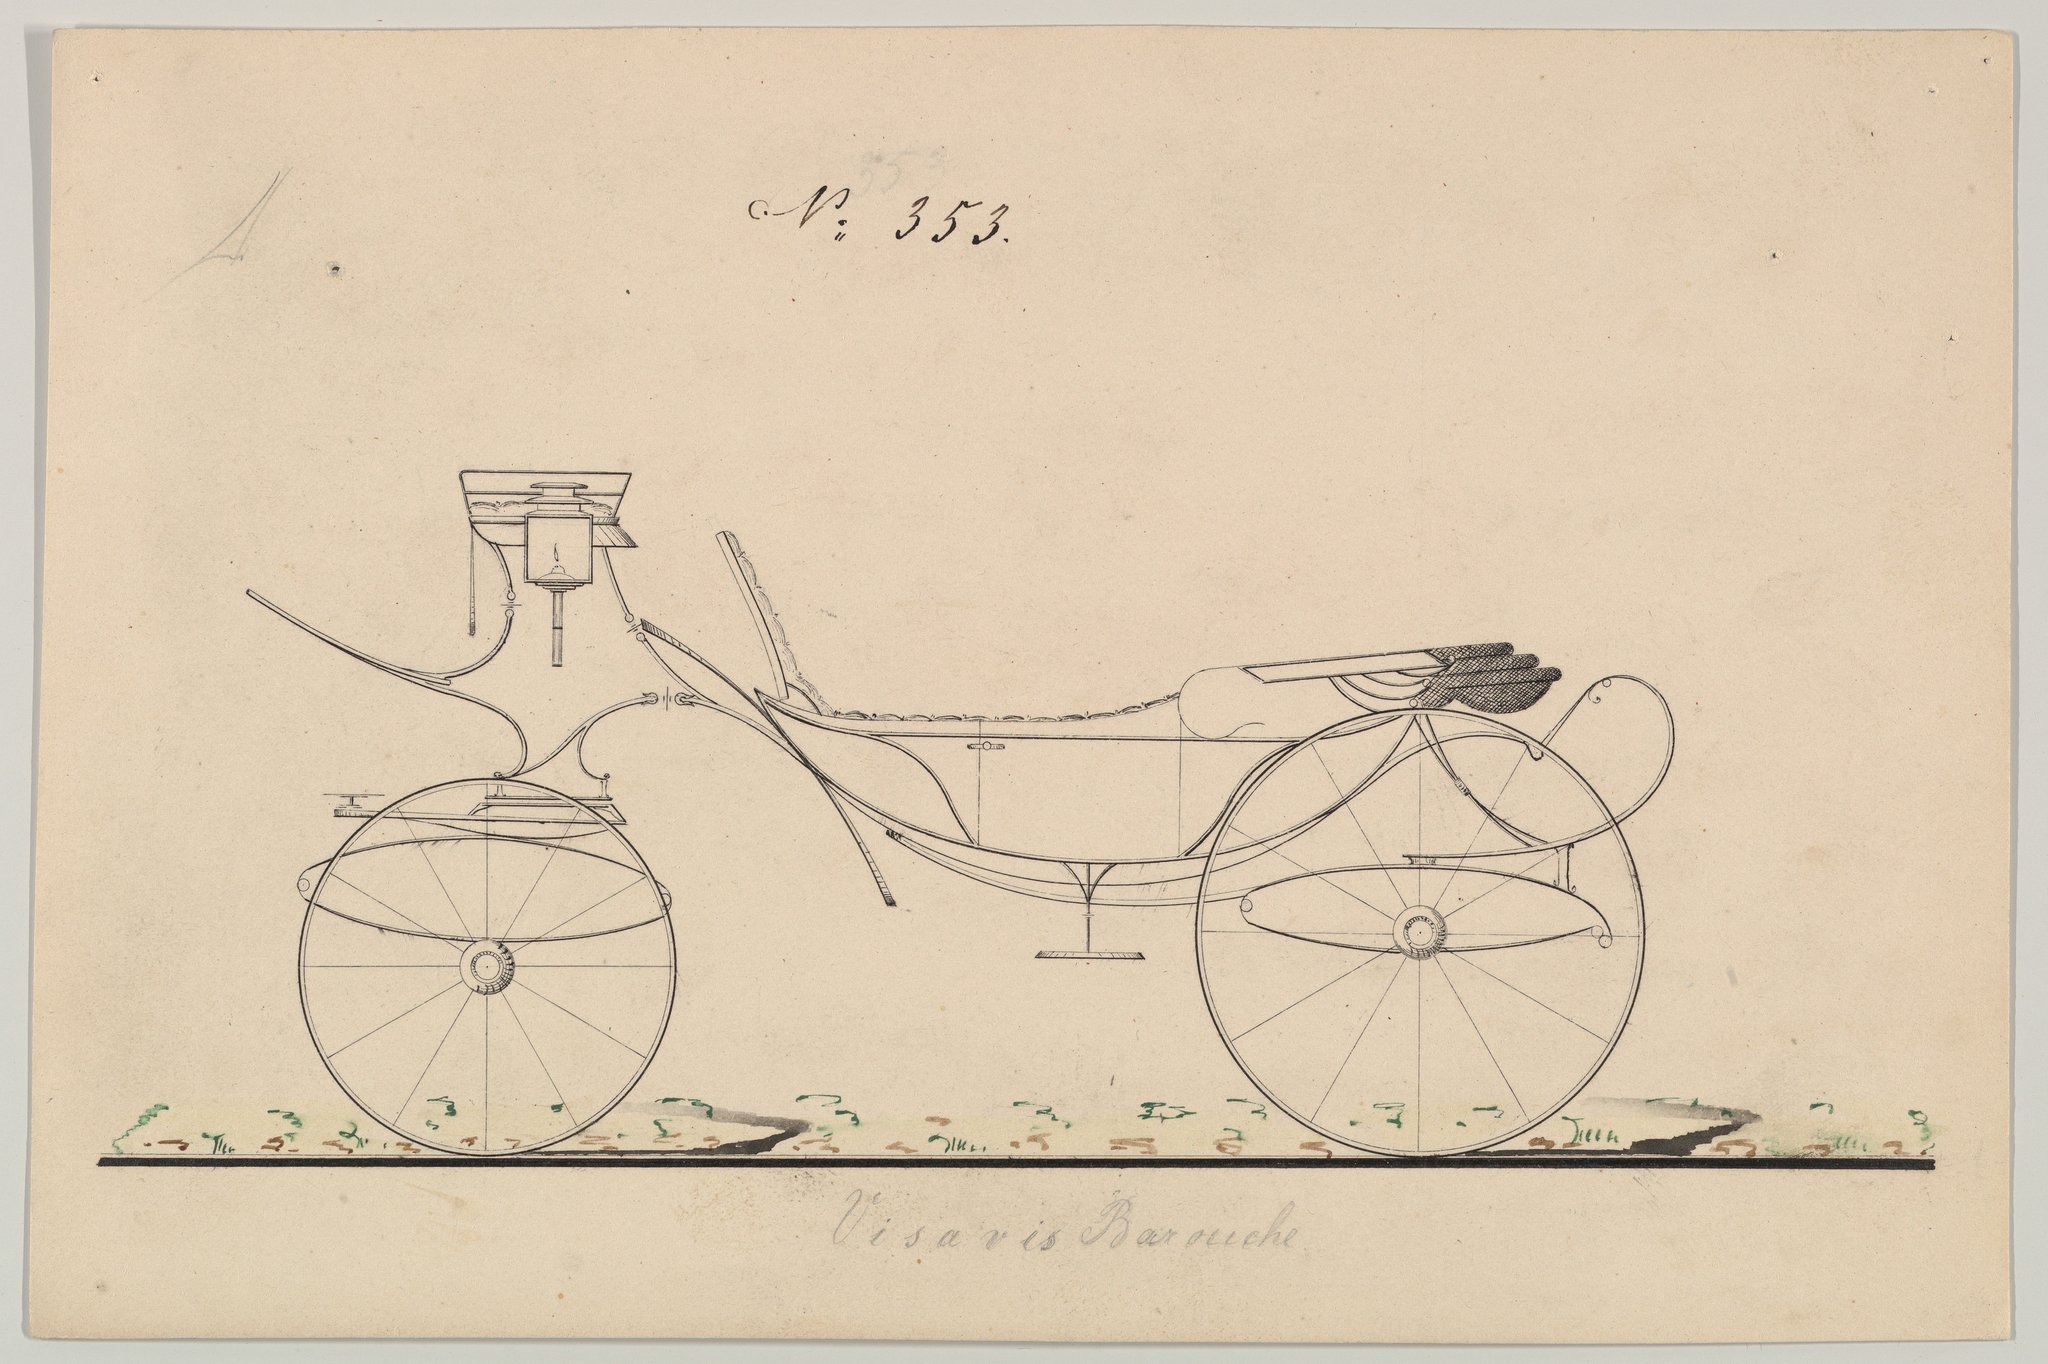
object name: drawing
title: Design for Vis-à-vis/ Barouche, no. 353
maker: brewster & co.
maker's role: manufacturer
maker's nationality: american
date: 1850-1870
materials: gouache, graphite, ink, watercolor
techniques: pen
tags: carriages